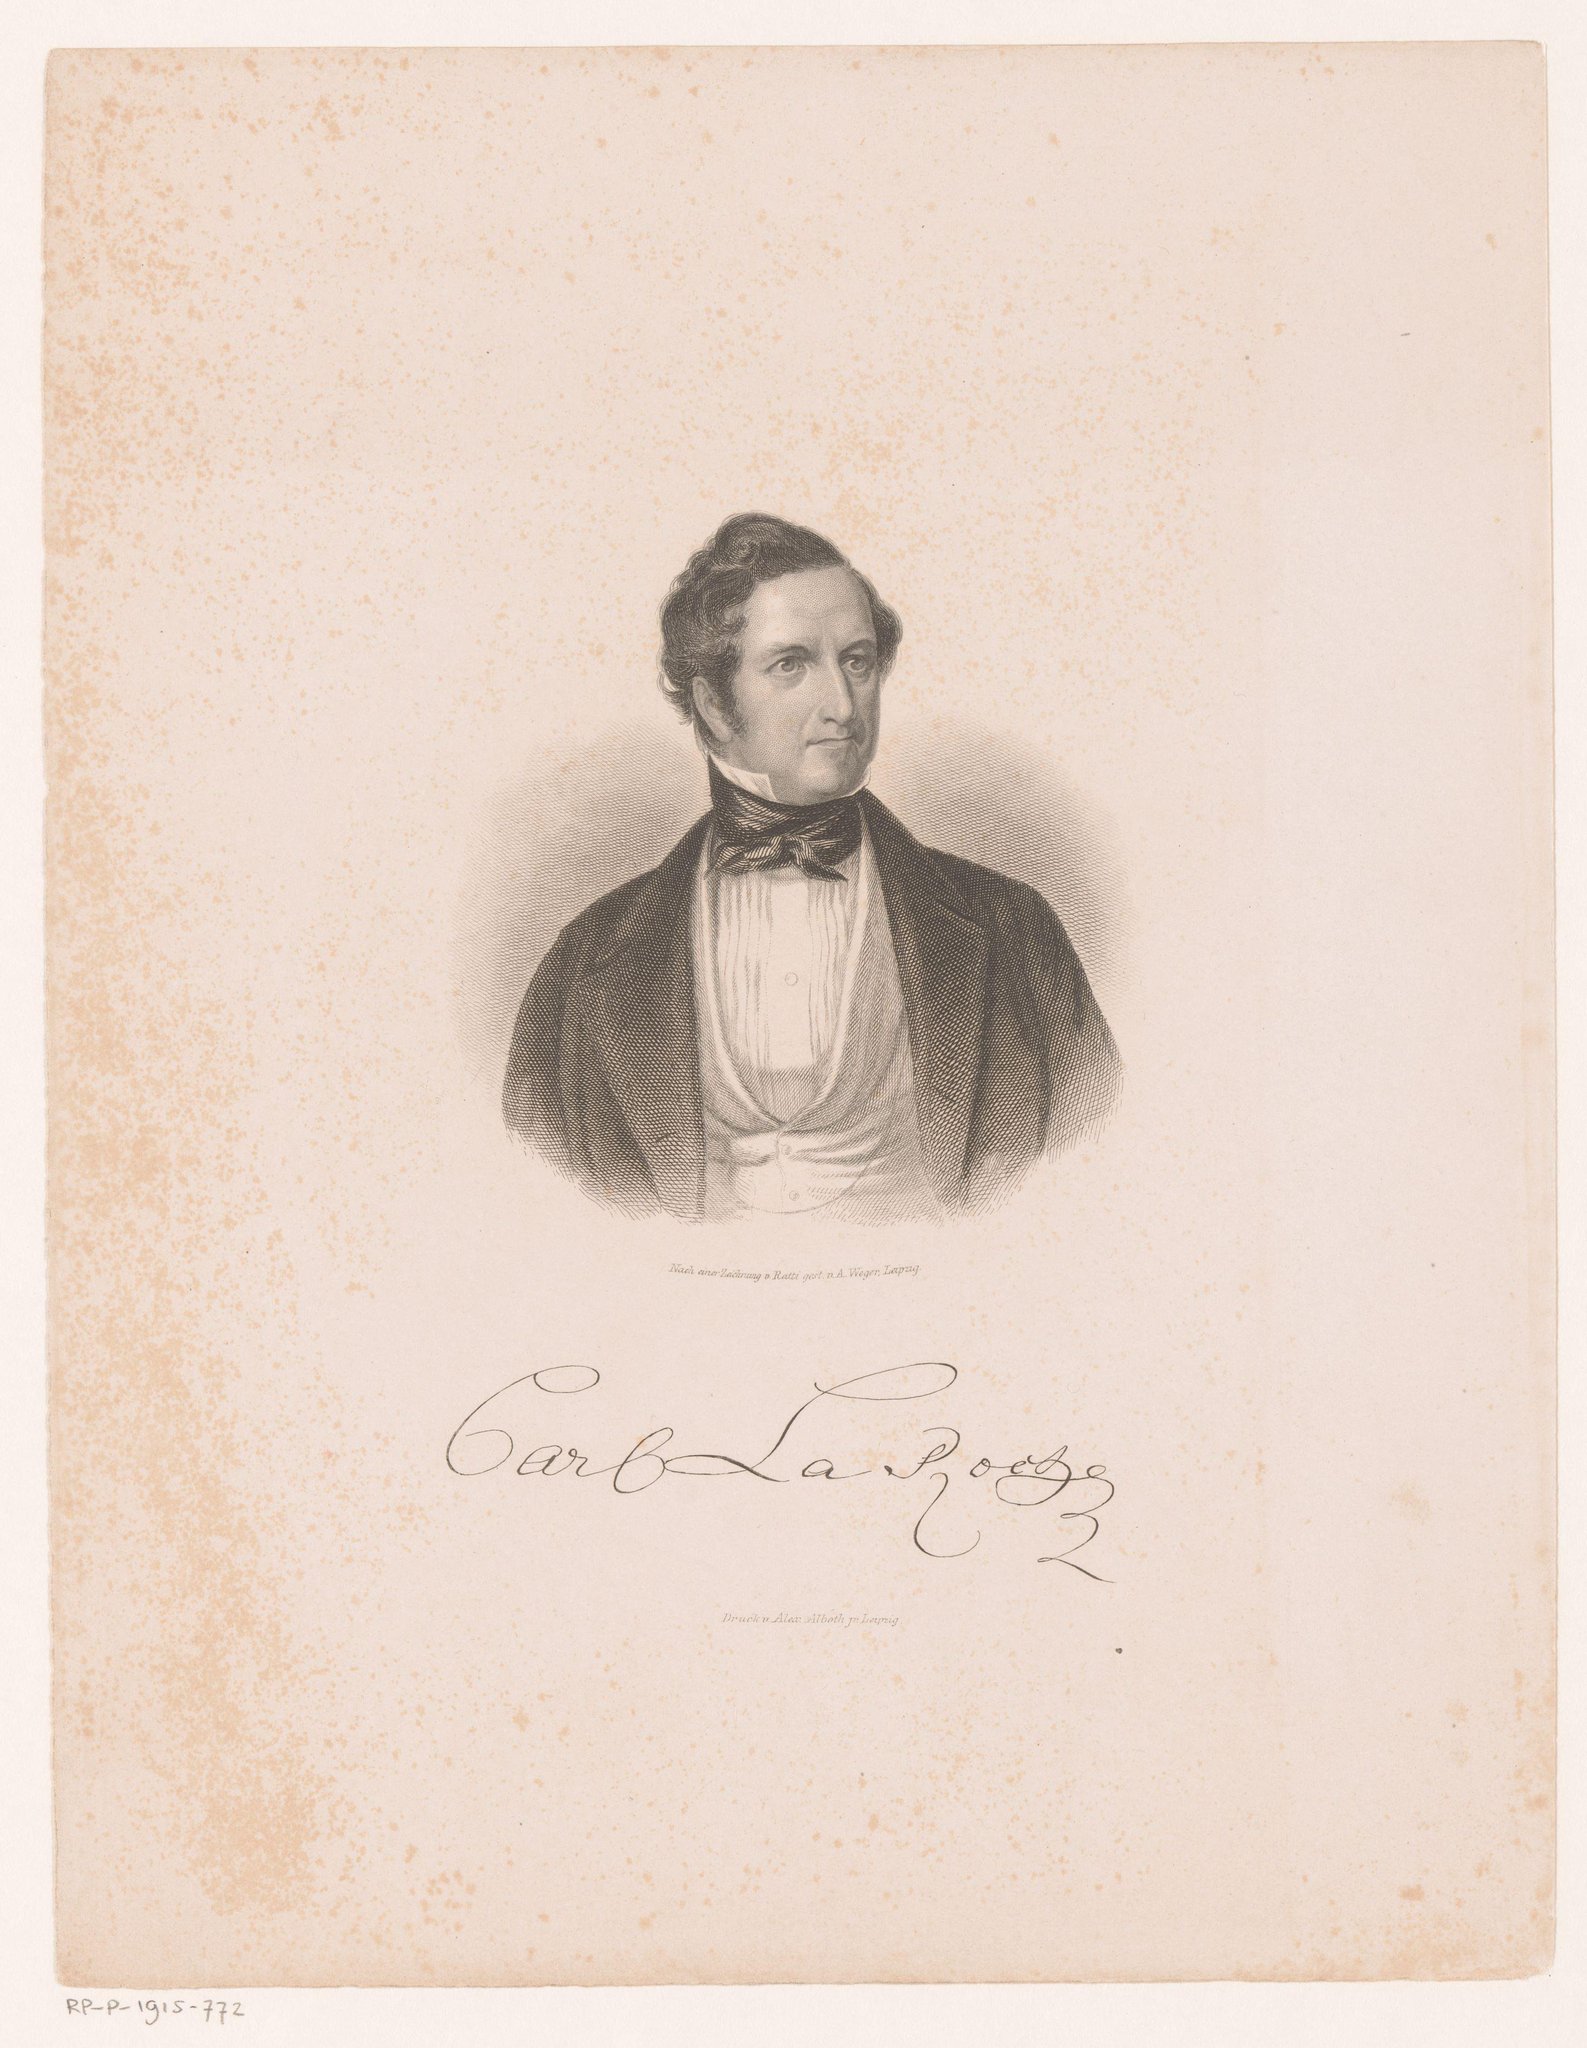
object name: print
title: Portret van Karl von La Roche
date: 1849-1892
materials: paper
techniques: engraving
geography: leipzig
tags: berlin, vienna, director, producer ~ the stage, historical persons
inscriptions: collector's mark: Lugt 2228